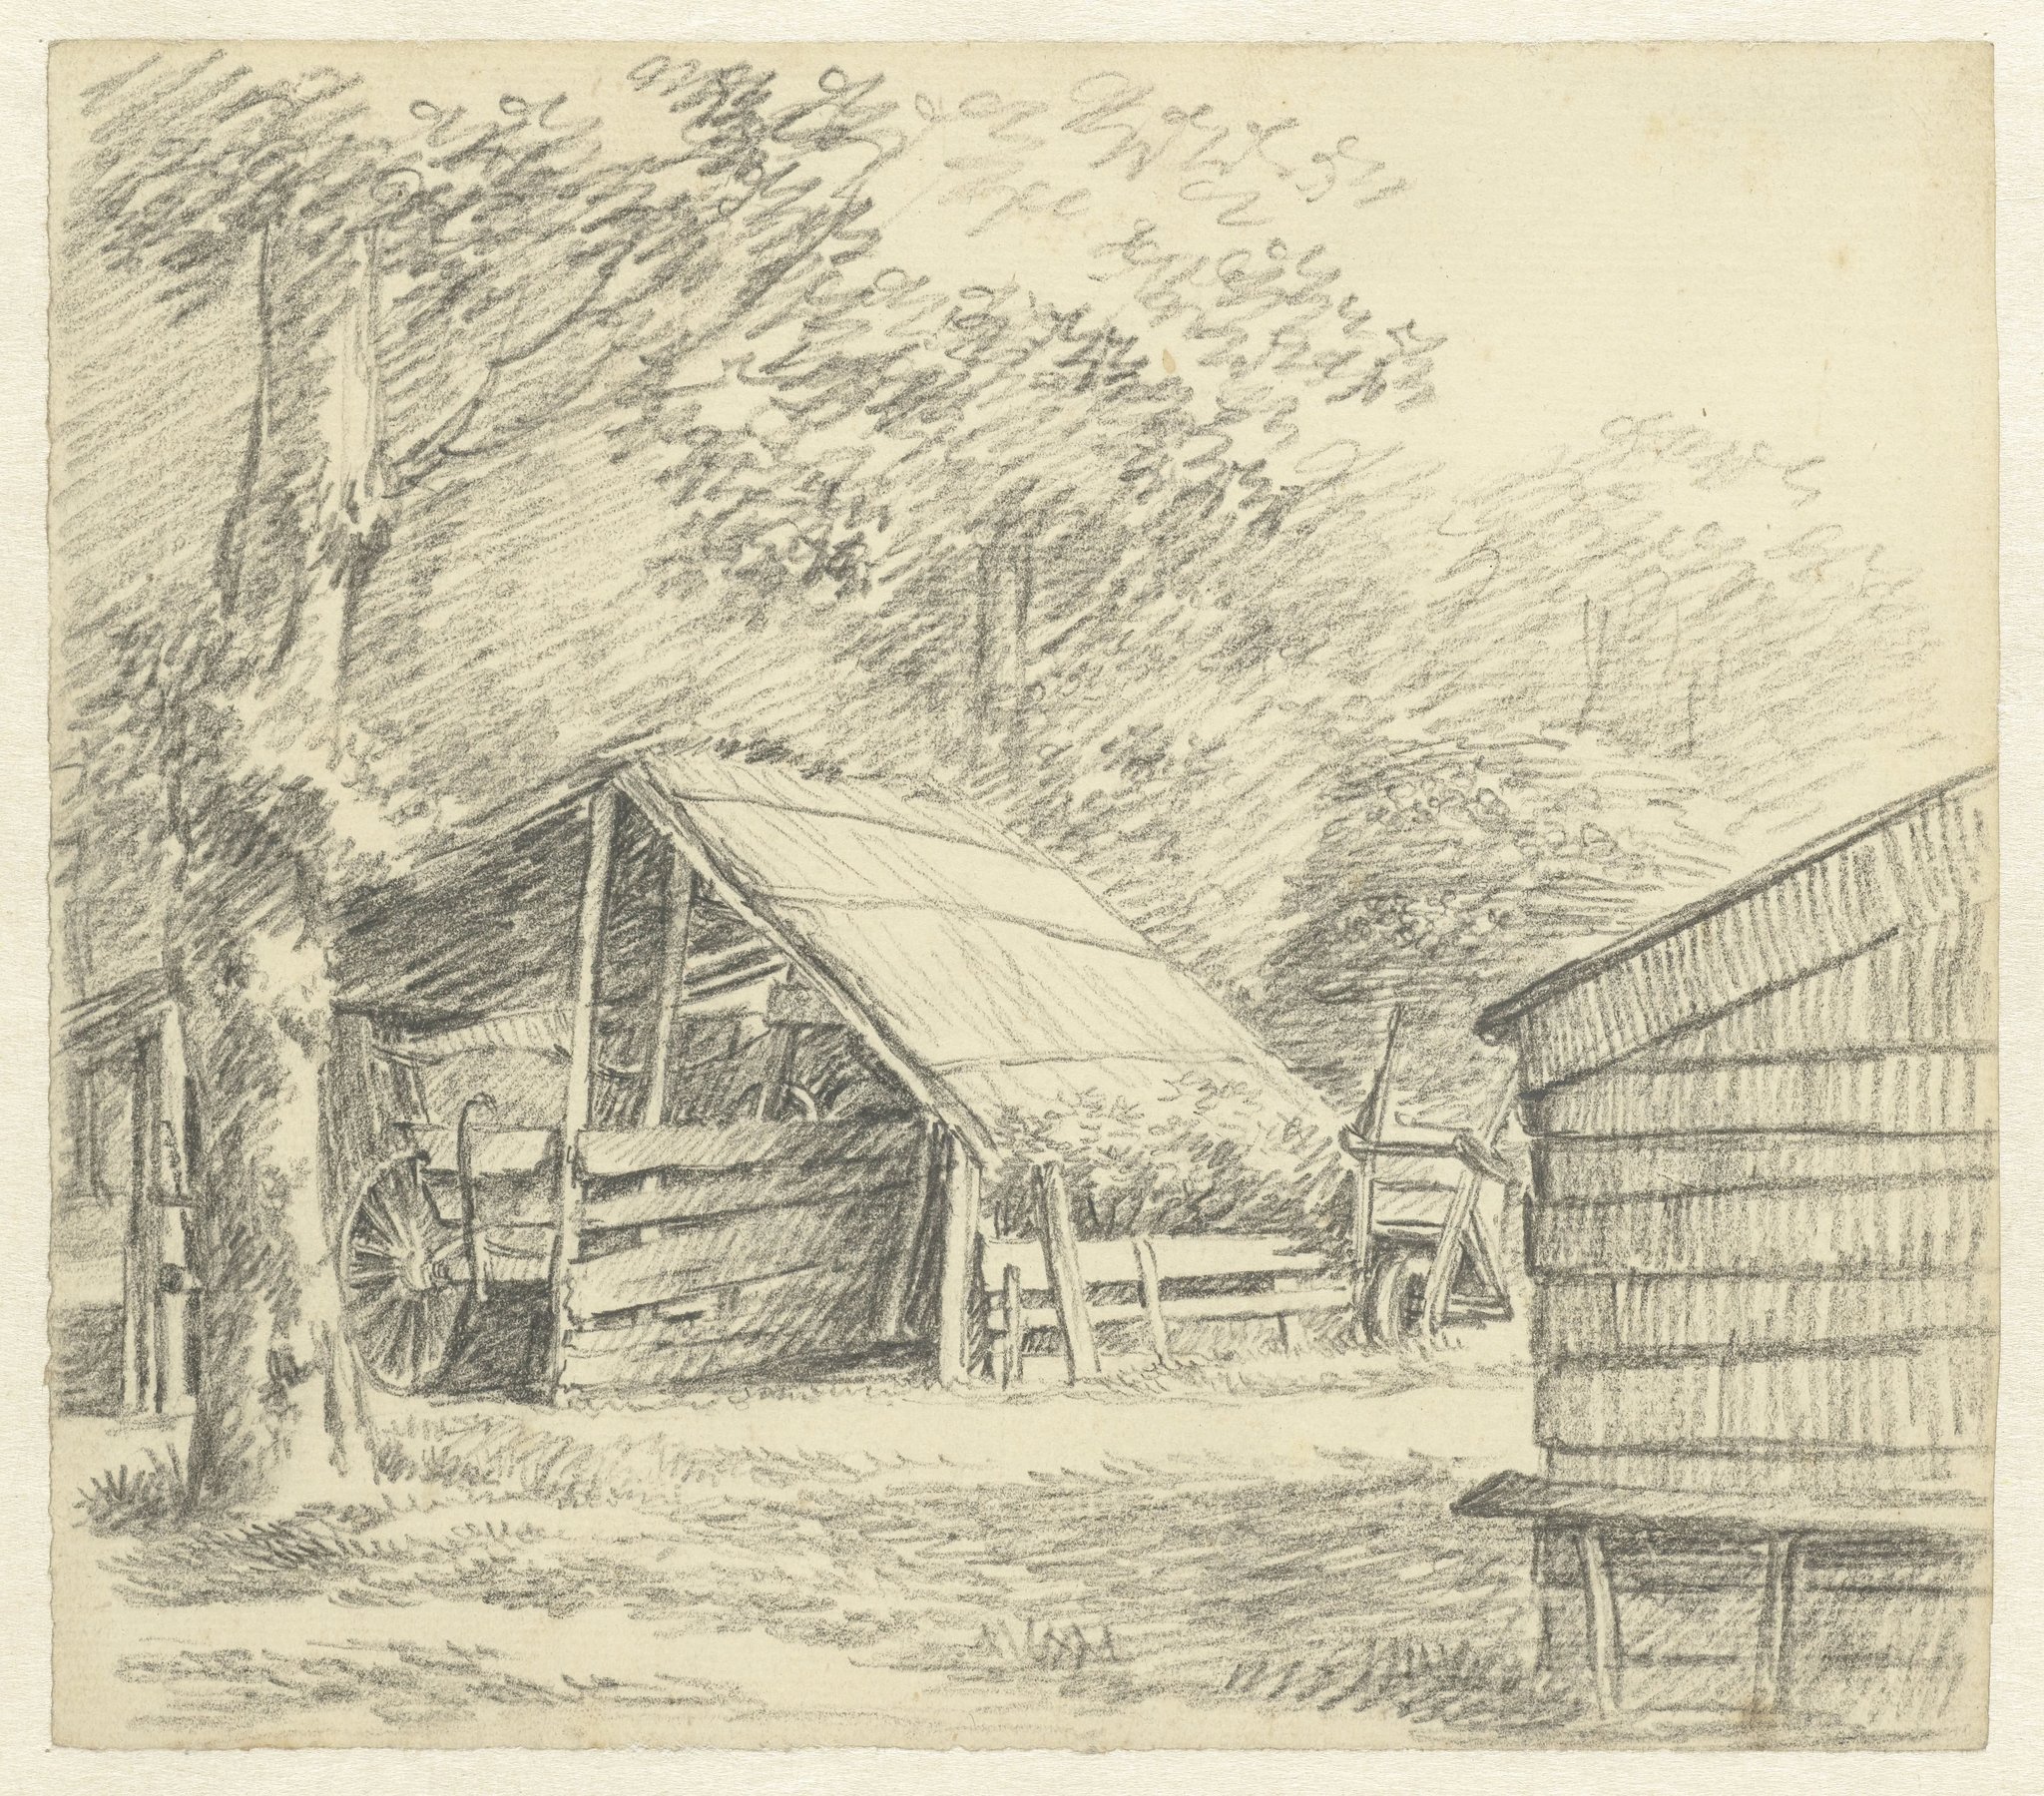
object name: drawing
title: Schuren tussen bomen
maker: egbert van drielst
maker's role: draughtsman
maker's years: 1745-1818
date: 1755-1818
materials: chalk, paper